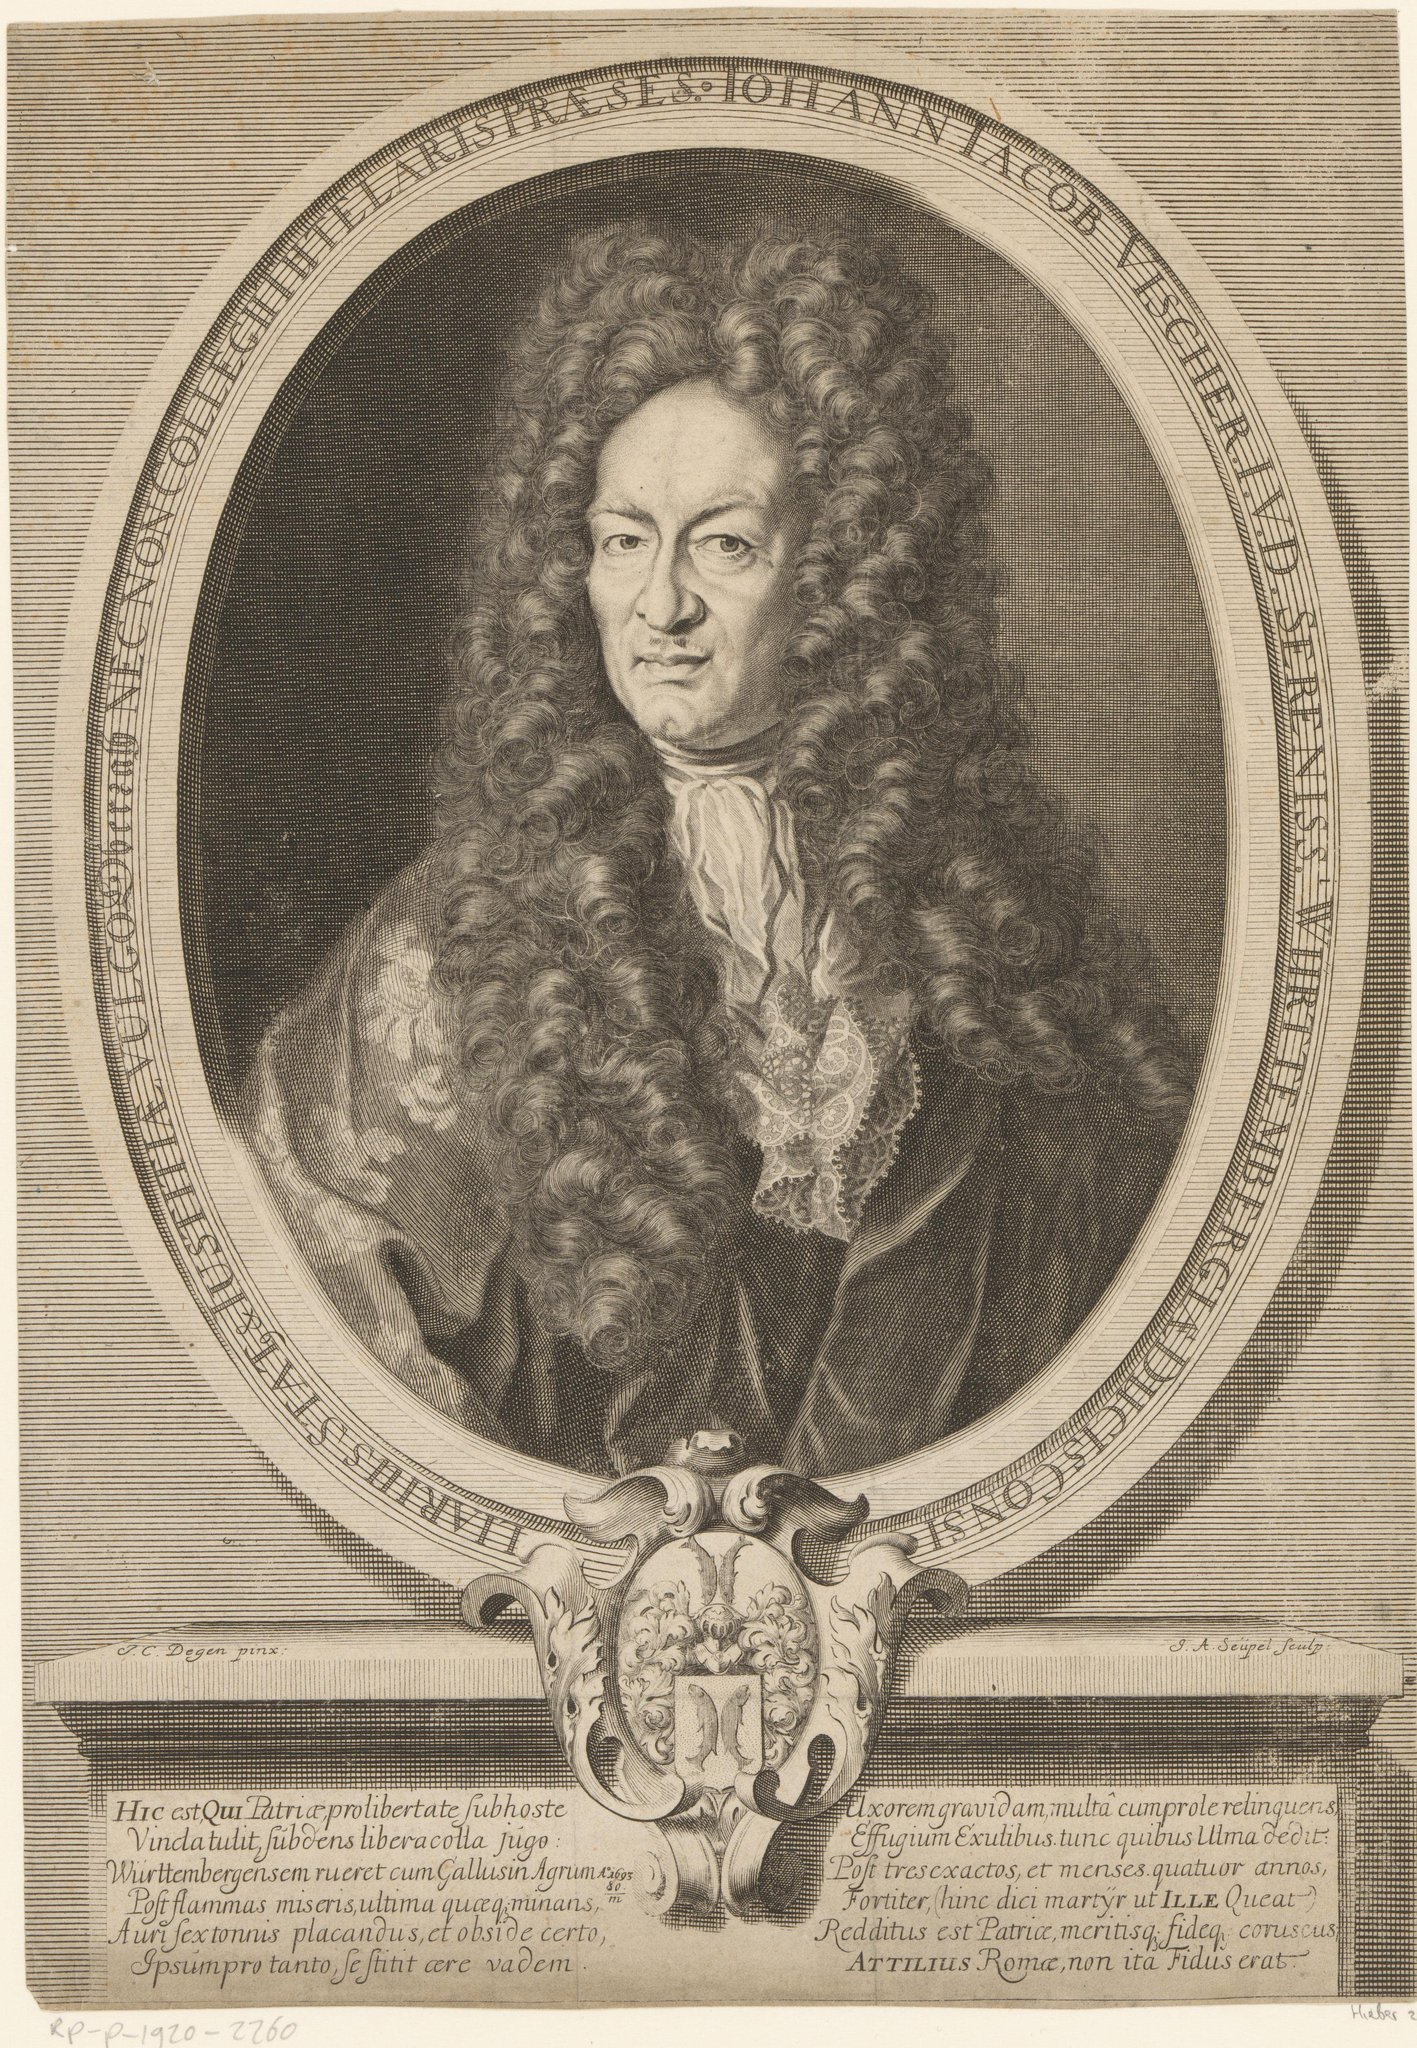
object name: print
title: Portret van Johann Jacob Visscher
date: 1672-1717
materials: paper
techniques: engraving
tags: historical persons, armorial bearing, heraldry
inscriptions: collector's mark: Lugt 2228